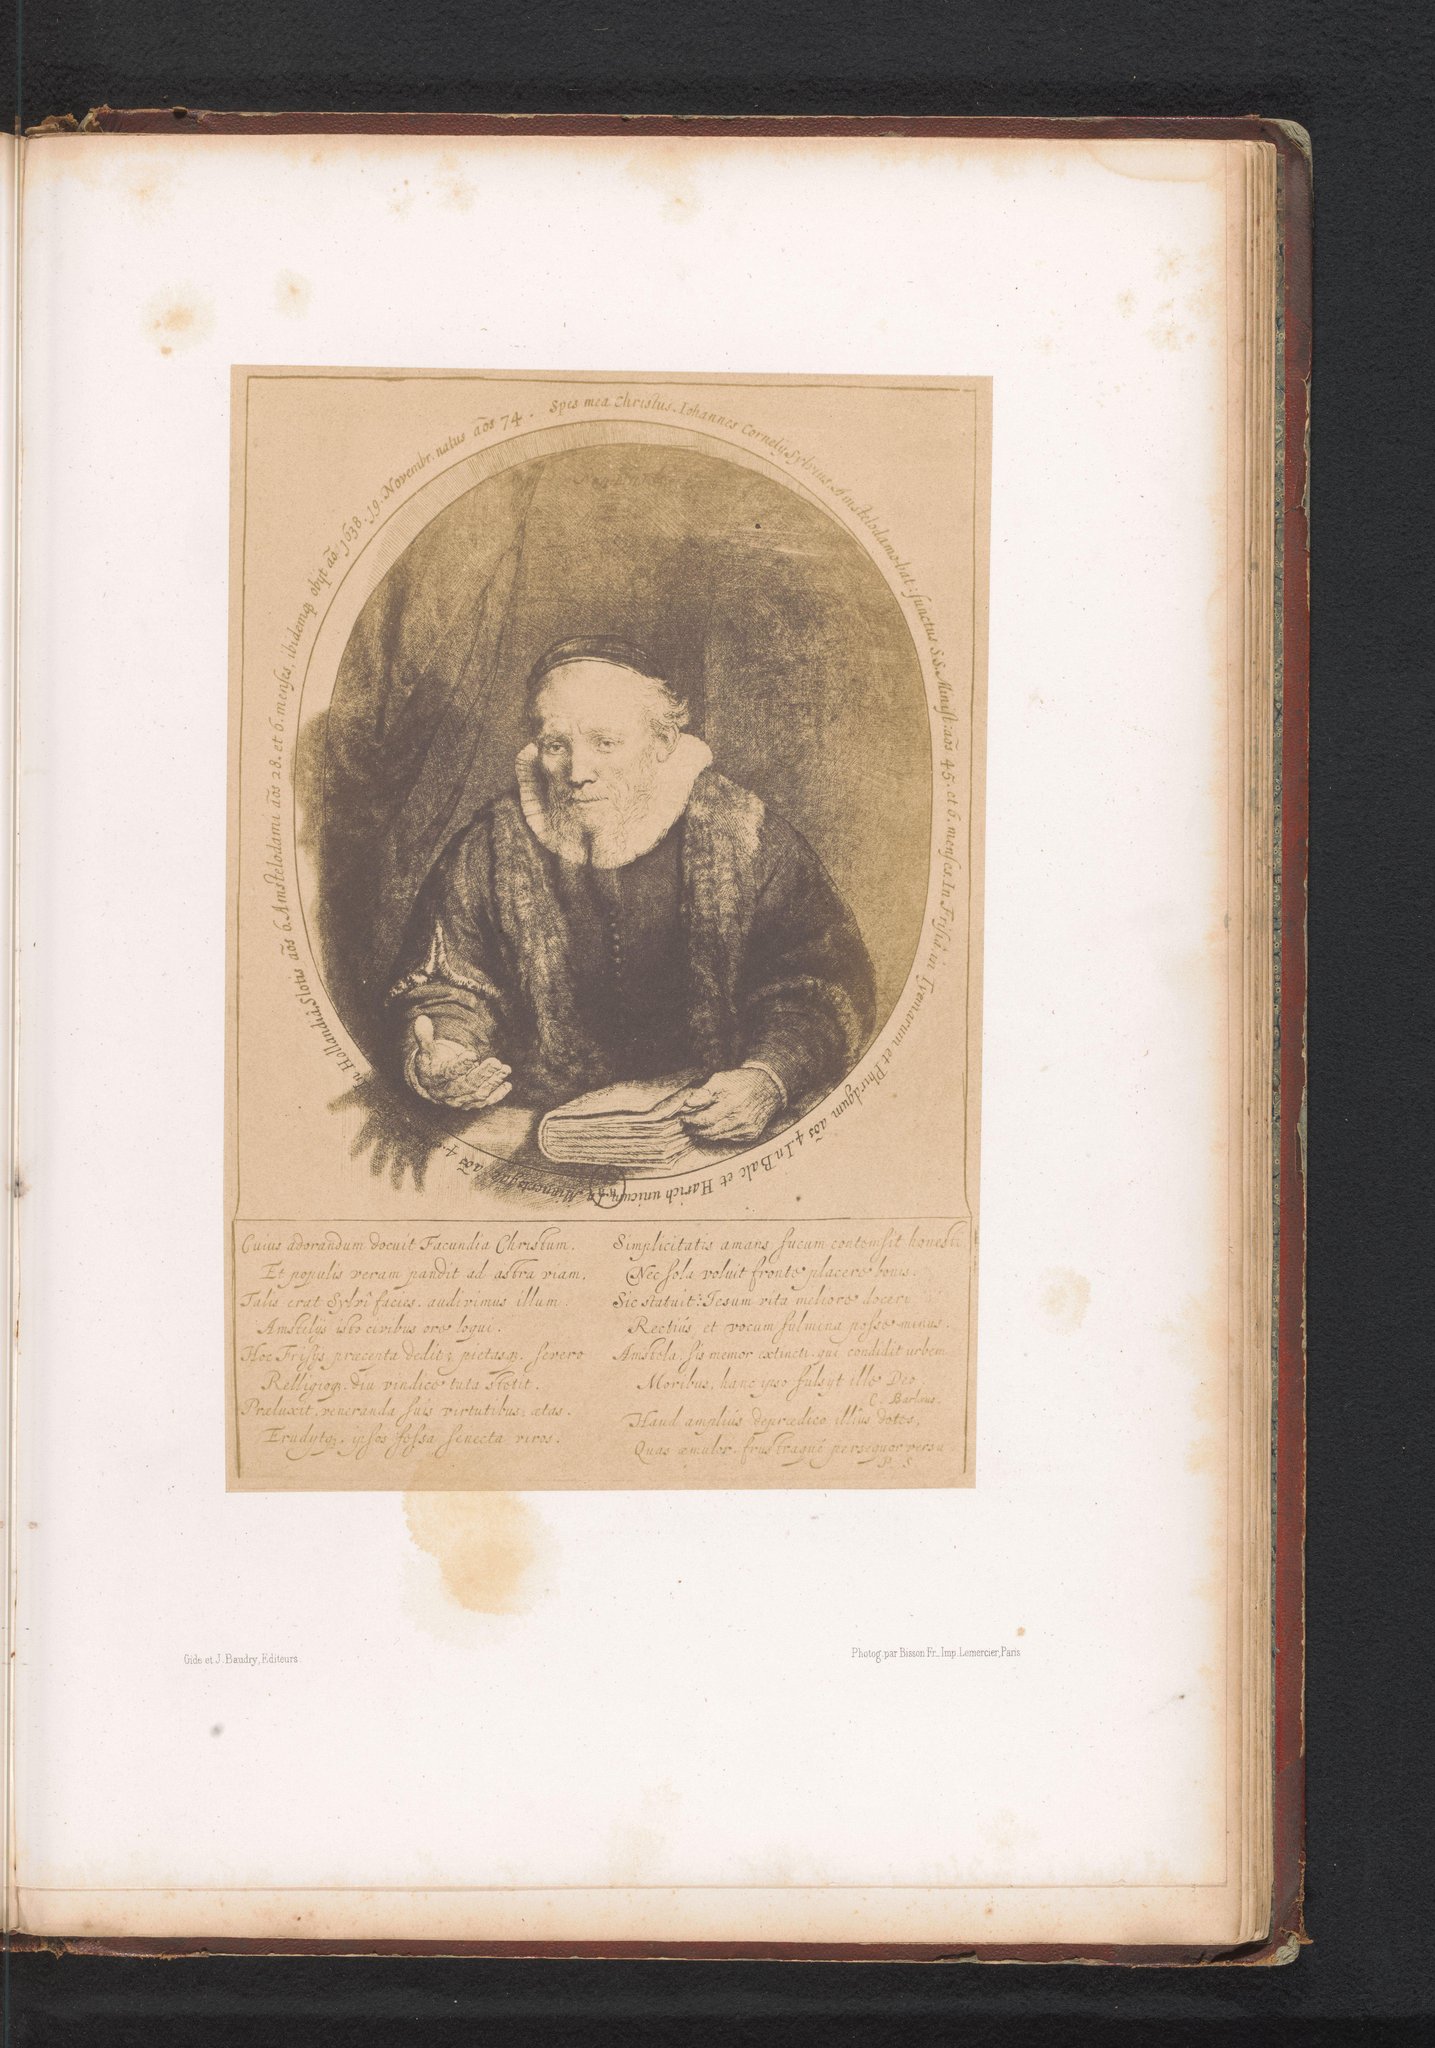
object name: page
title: Fotoreproductie van een ets van een portret van Johannes Cornelisz. Silvius door Rembrandt van Rijn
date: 1848-1853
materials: photographic support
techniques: salted paper print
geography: paris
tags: historical persons